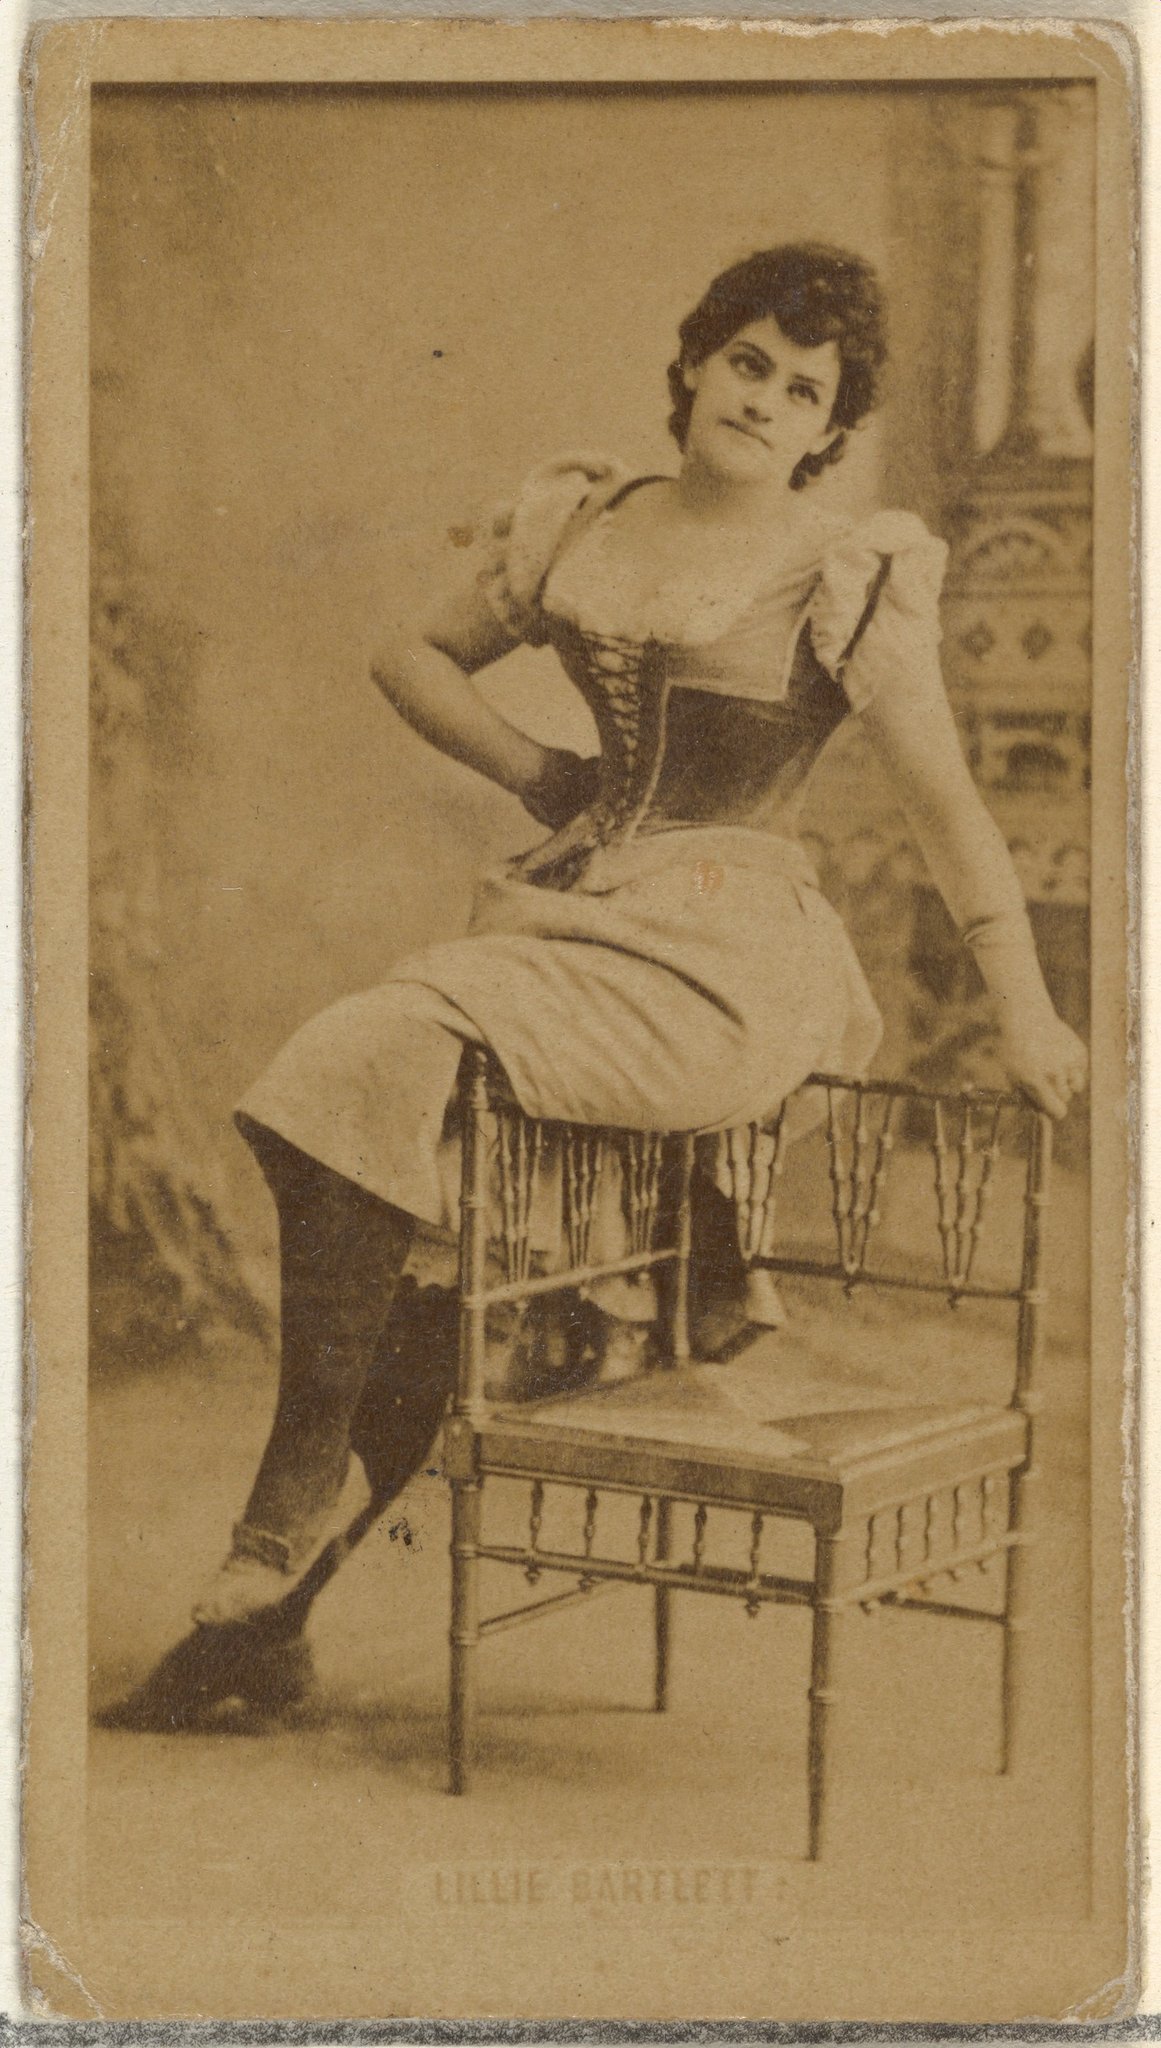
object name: photograph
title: Lillie Bartlett, from the Actors and Actresses series (N145-8) issued by Duke Sons & Co. to promote Duke Cigarettes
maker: w. duke, sons & co.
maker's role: publisher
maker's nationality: american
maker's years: 1870-1920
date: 1891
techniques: albumen silver print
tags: portraits,women,actresses